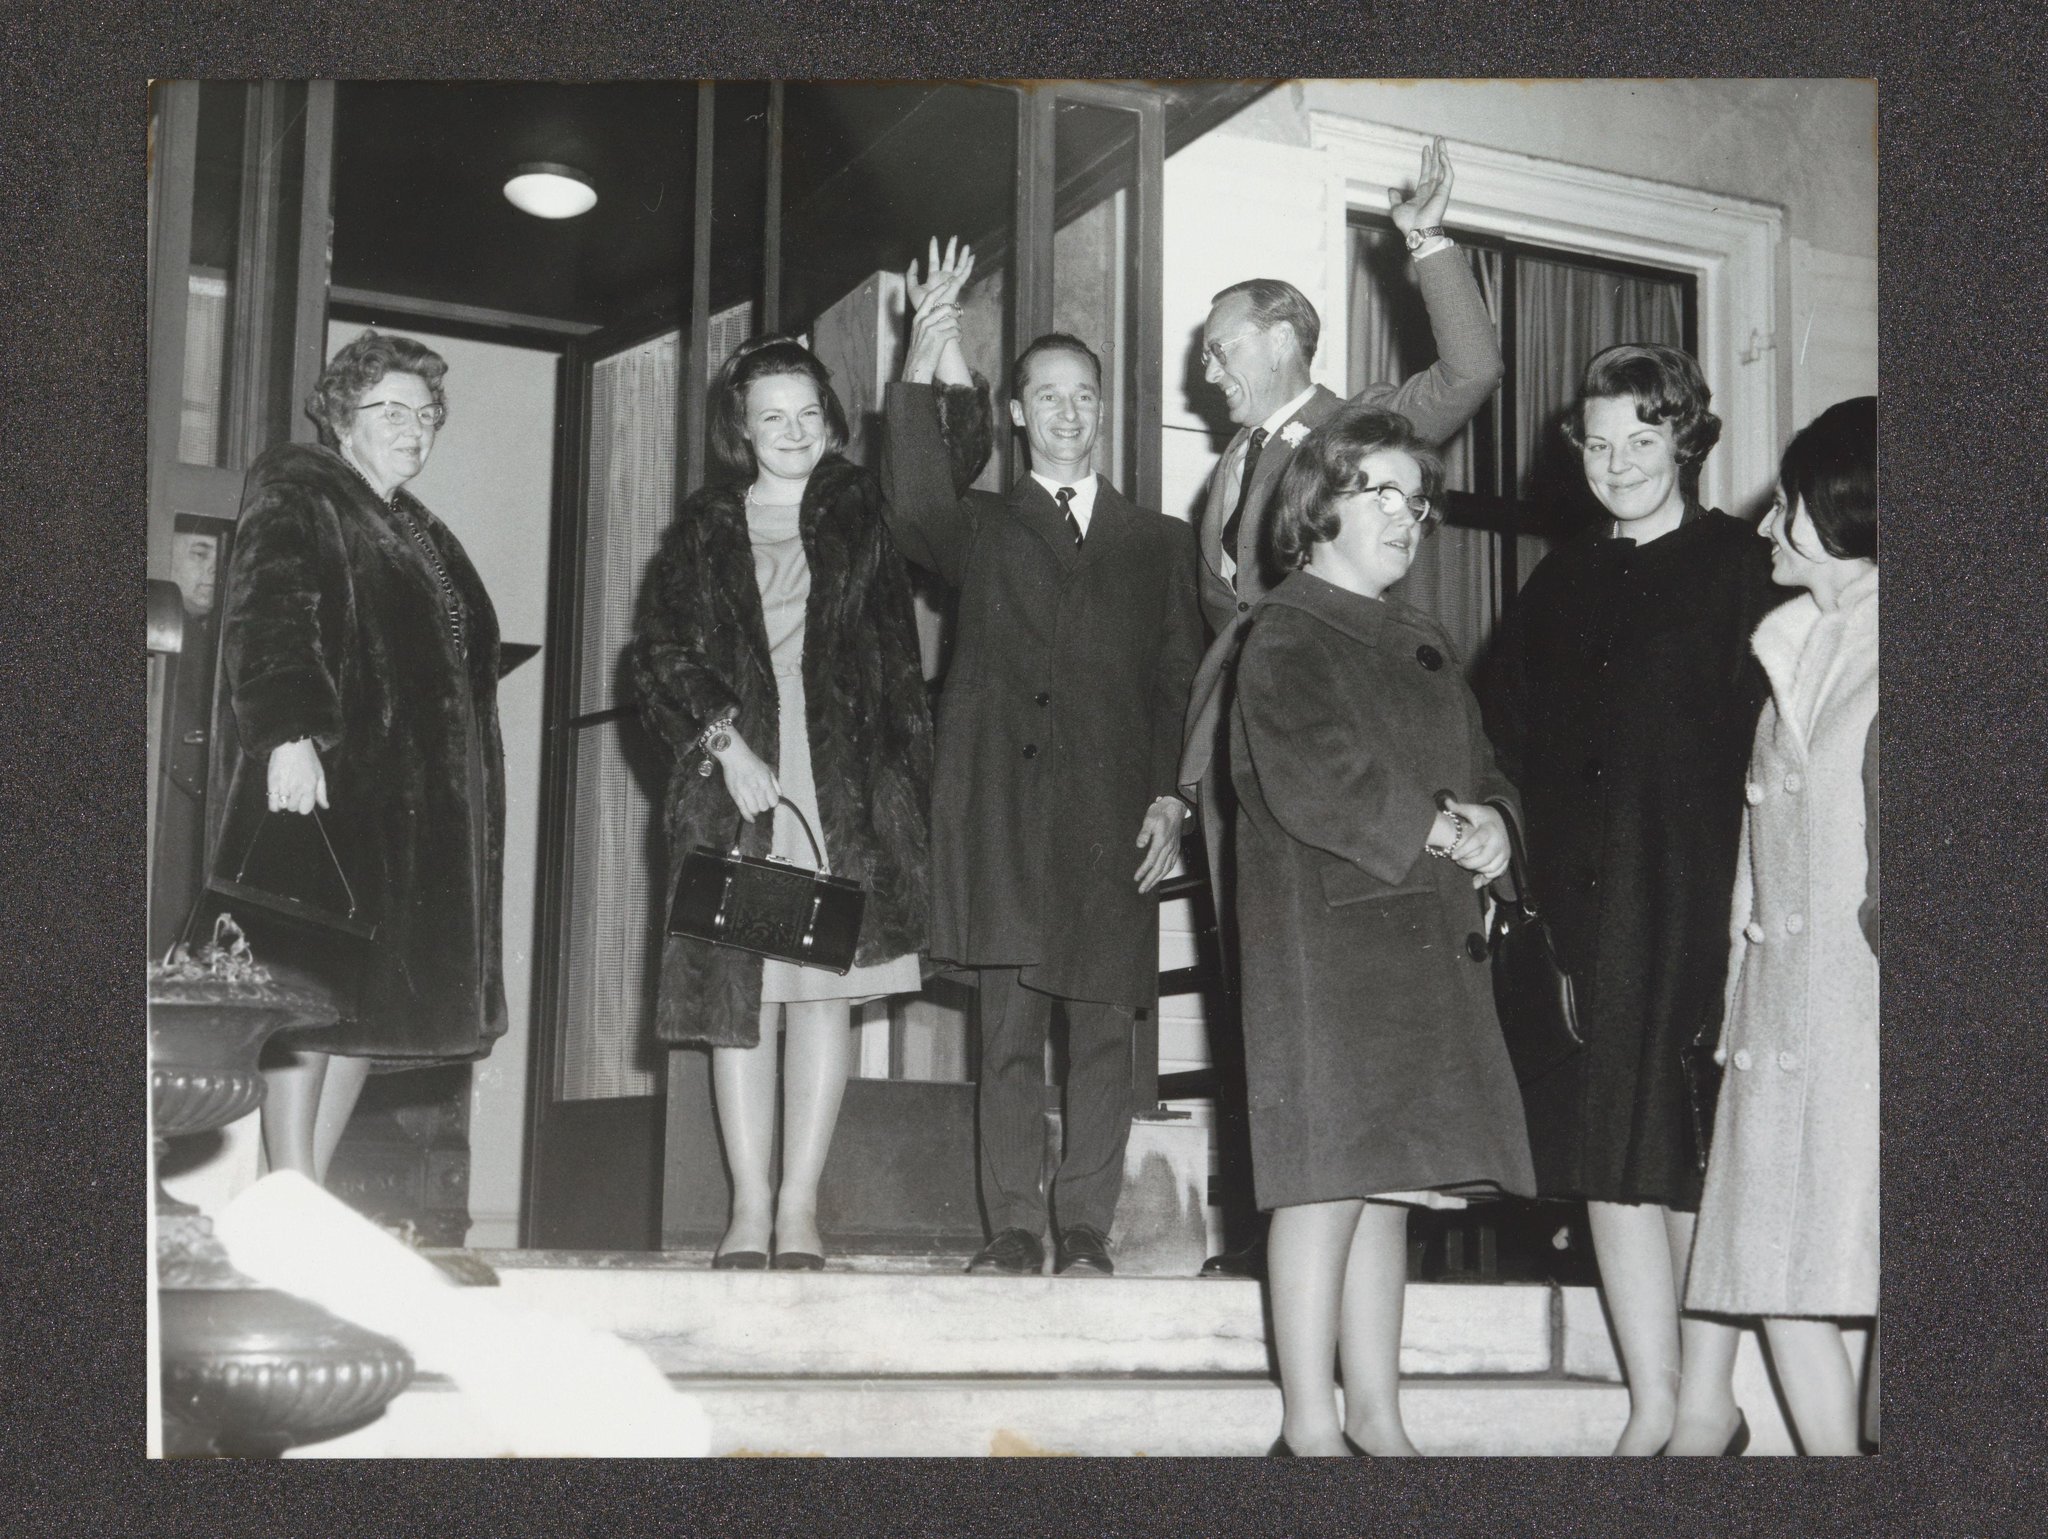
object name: photograph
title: Prinses Irene en Prins Carlos, aankomst op paleis Soestdijk zaterdagavond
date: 1959-1964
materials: paper, photographic support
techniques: gelatin silver print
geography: soestdijk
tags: bernhard (prins der nederlanden), beatrix (koningin der nederlanden), juliana of the netherlands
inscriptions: inscription: ‘De hele koninklijk familie op het bordes. v.l.n.r. Koningin Juliana - Prinses Irene - Prins Carlos - Prins Bernhard - Prinses Christina - Prinses Beatrix en een zuster van Prins CArlos, Prinses Cecile’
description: Prinses Irene met prins Carlos, om hen heen staan koningin Juliana, prins Bernhard, en de prinsessen Beatrix en Marijke.